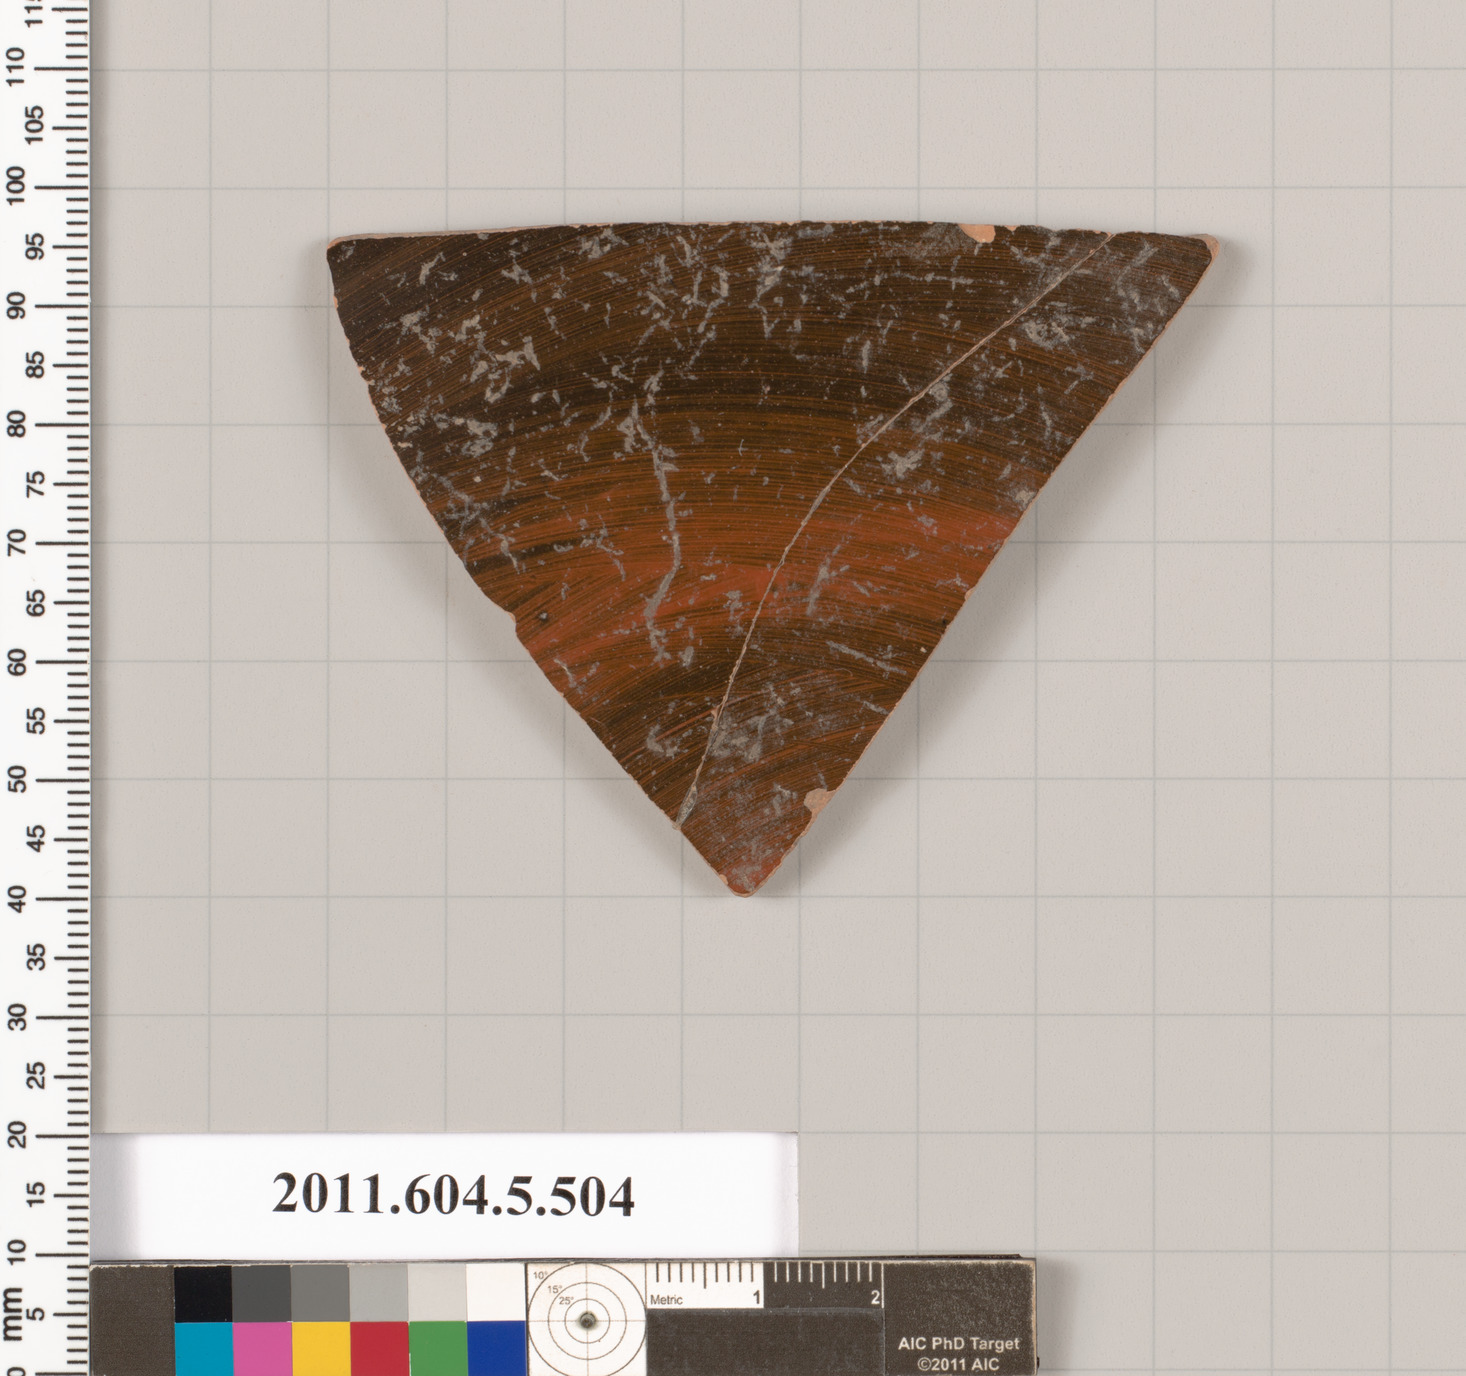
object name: kylix fragment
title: Terracotta fragment of a kylix (drinking cup)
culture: greek, attic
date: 600-401 BCE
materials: terracotta